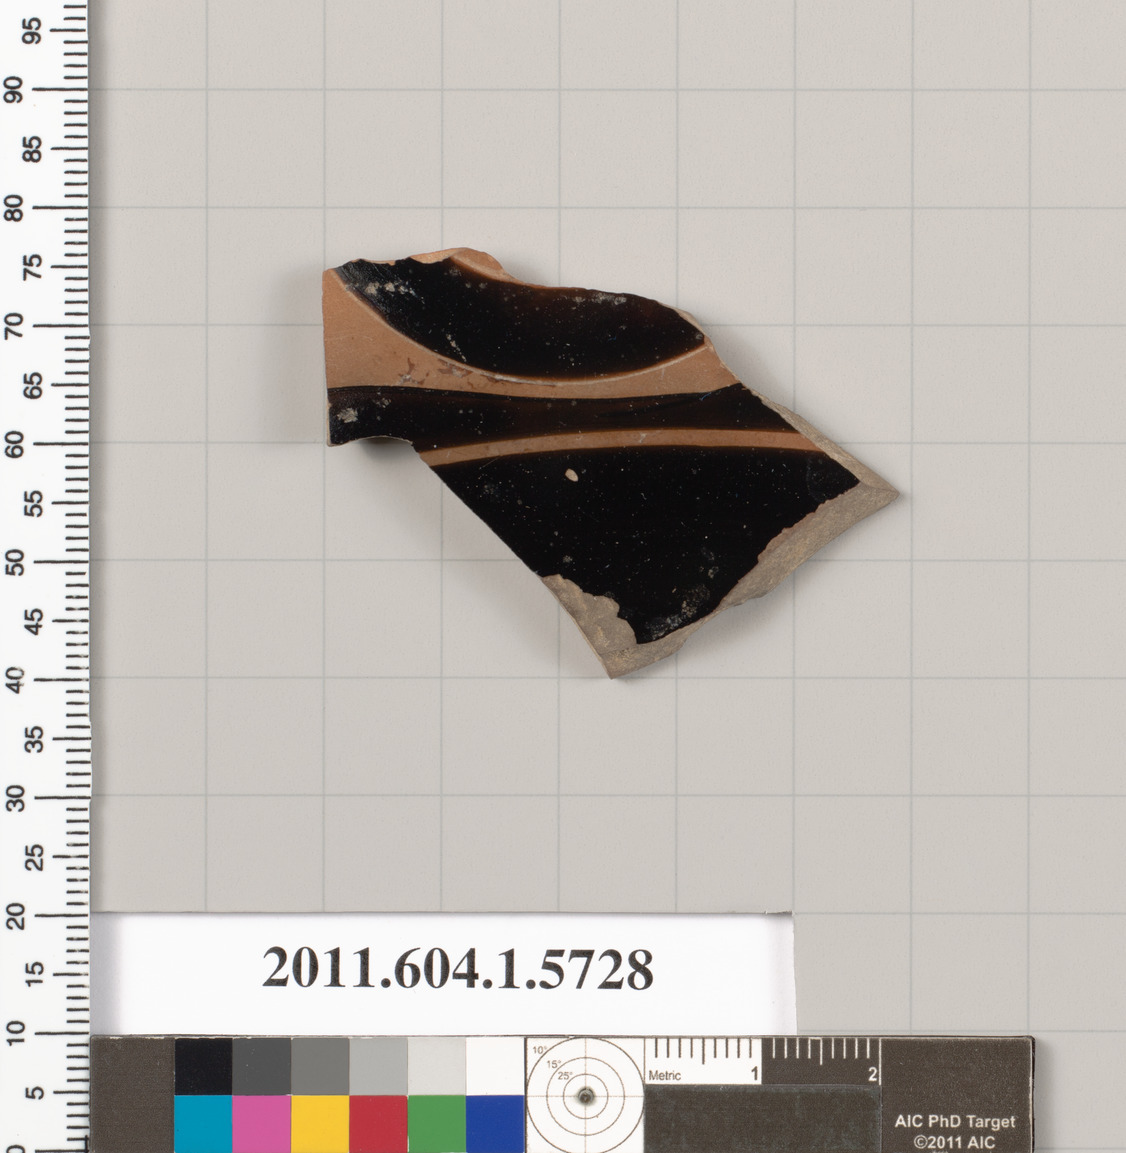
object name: kylix fragment, eye cup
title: Terracotta fragment of a kylix: eye-cup (drinking cup)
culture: greek, attic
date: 525-510 BCE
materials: terracotta